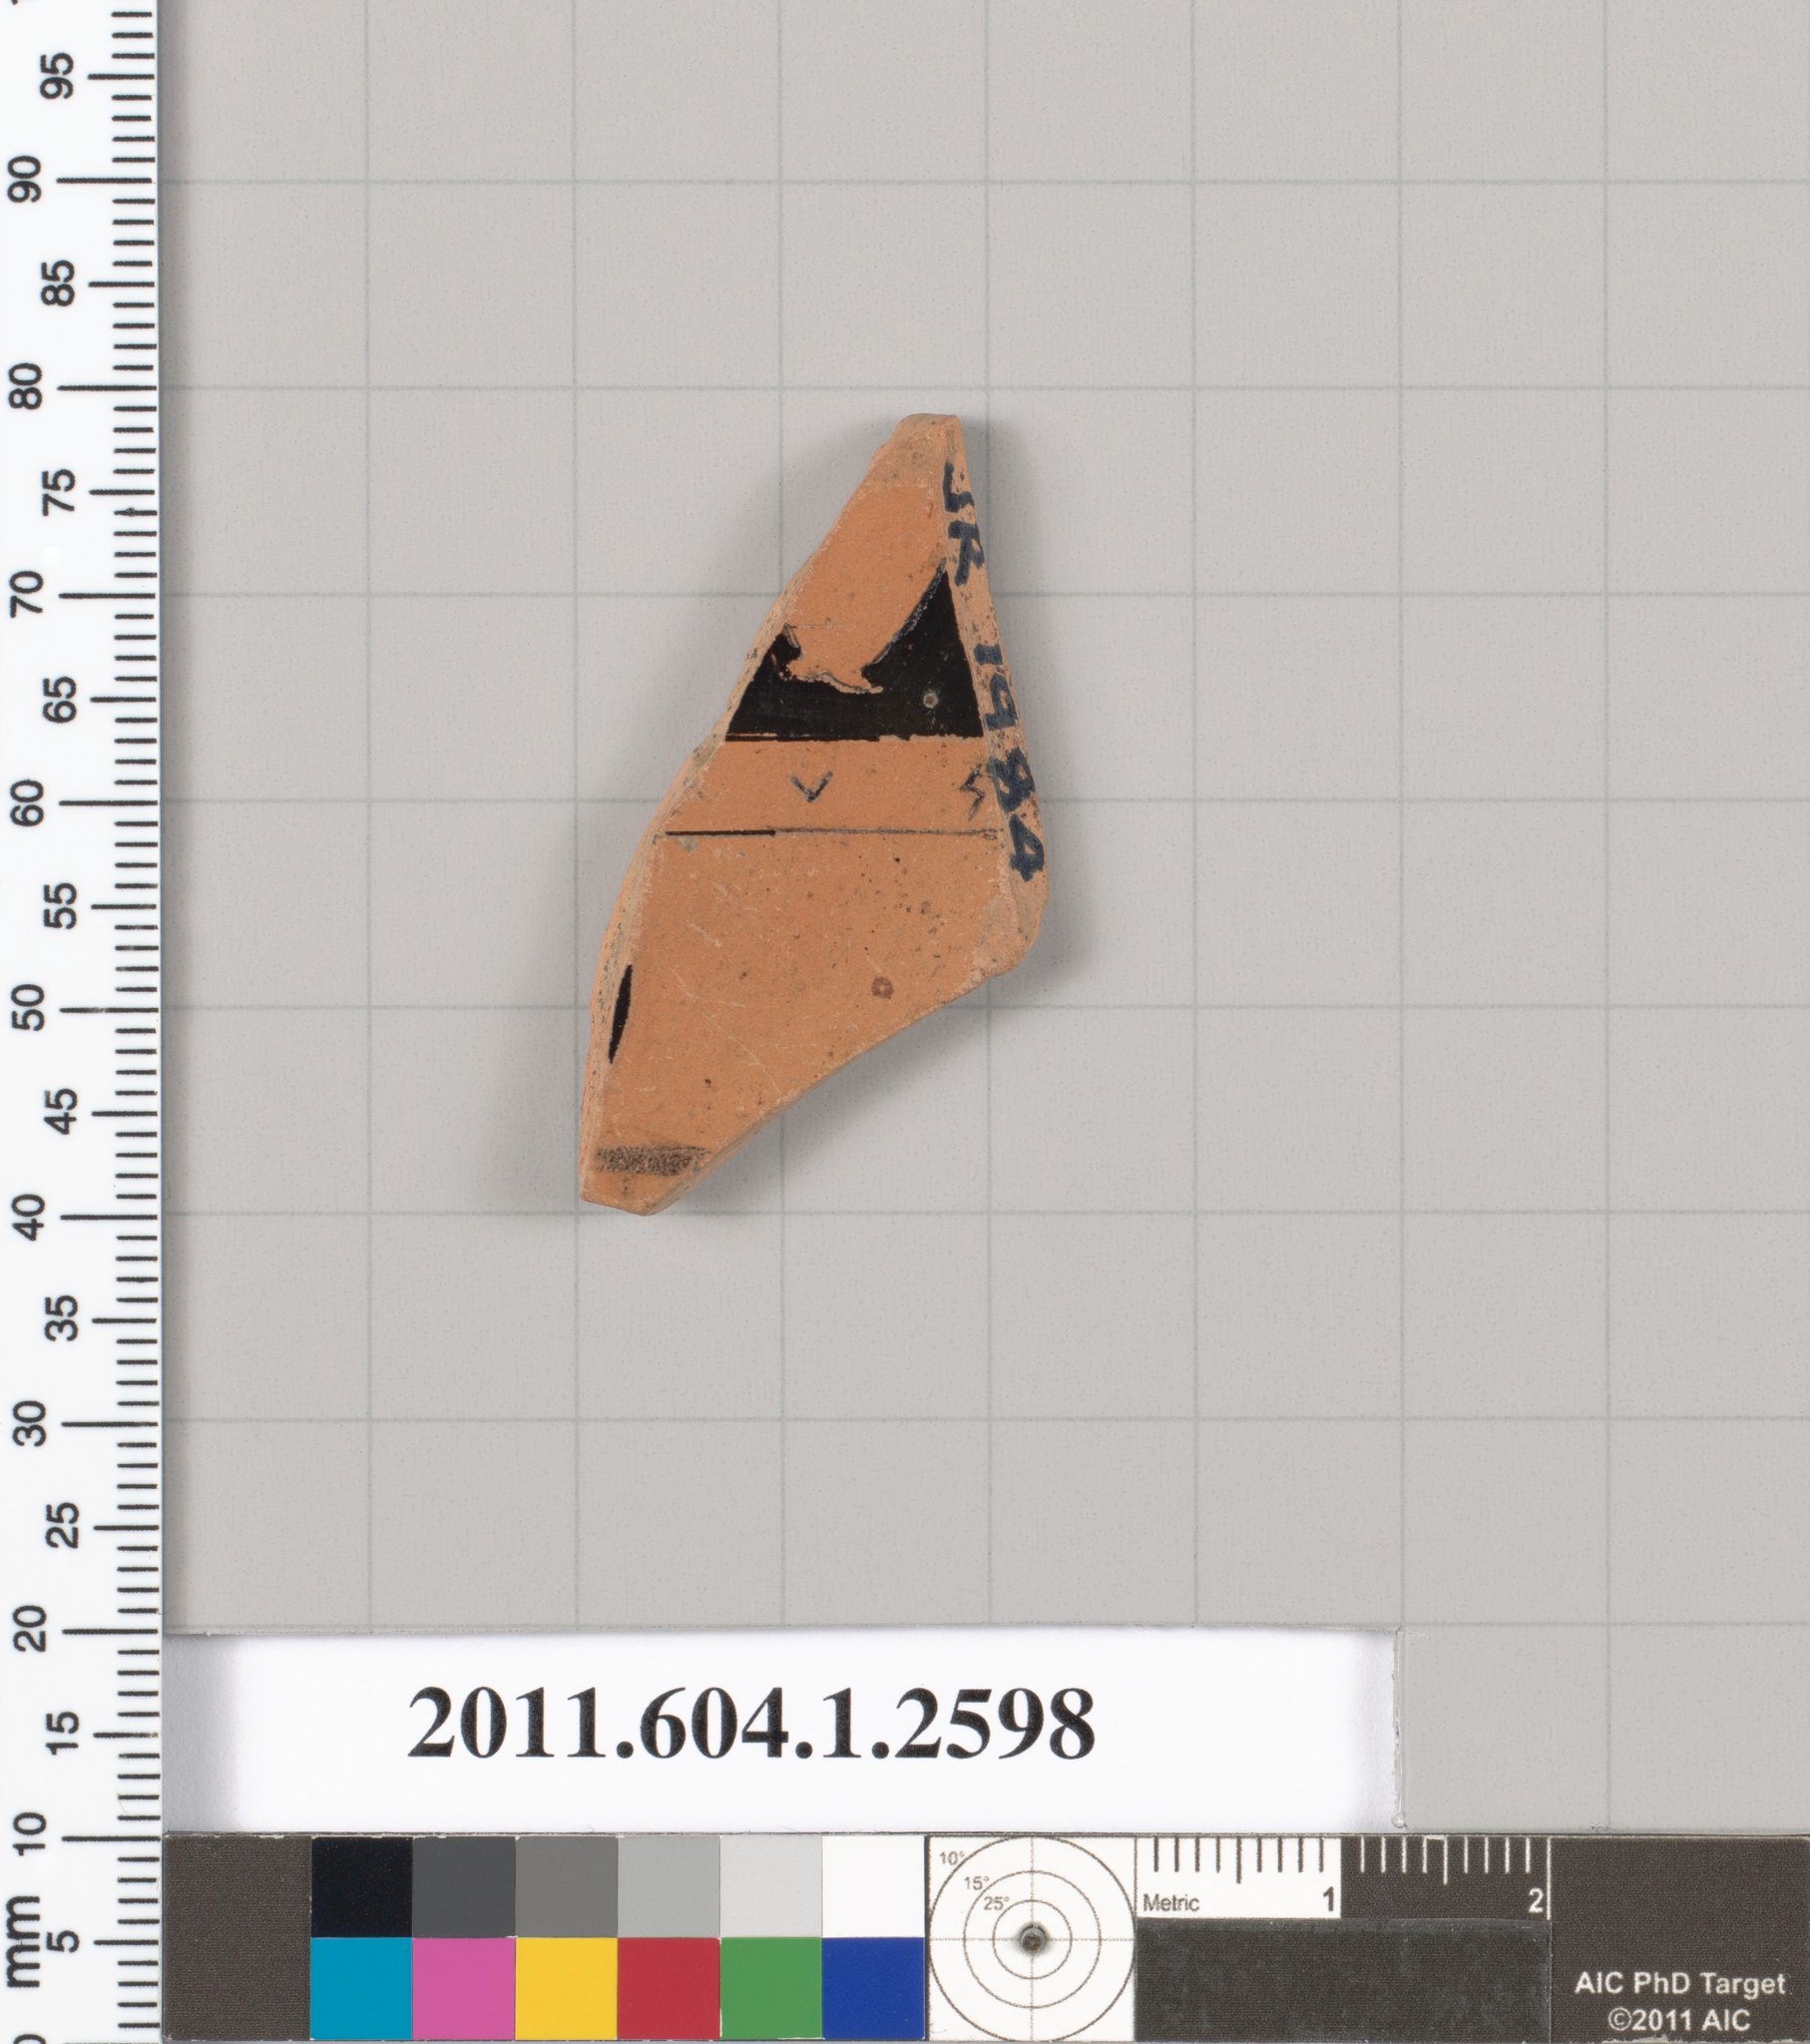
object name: kylix fragment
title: Terracotta fragment of a kylix (drinking cup)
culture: greek, attic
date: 500-480 BCE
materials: terracotta